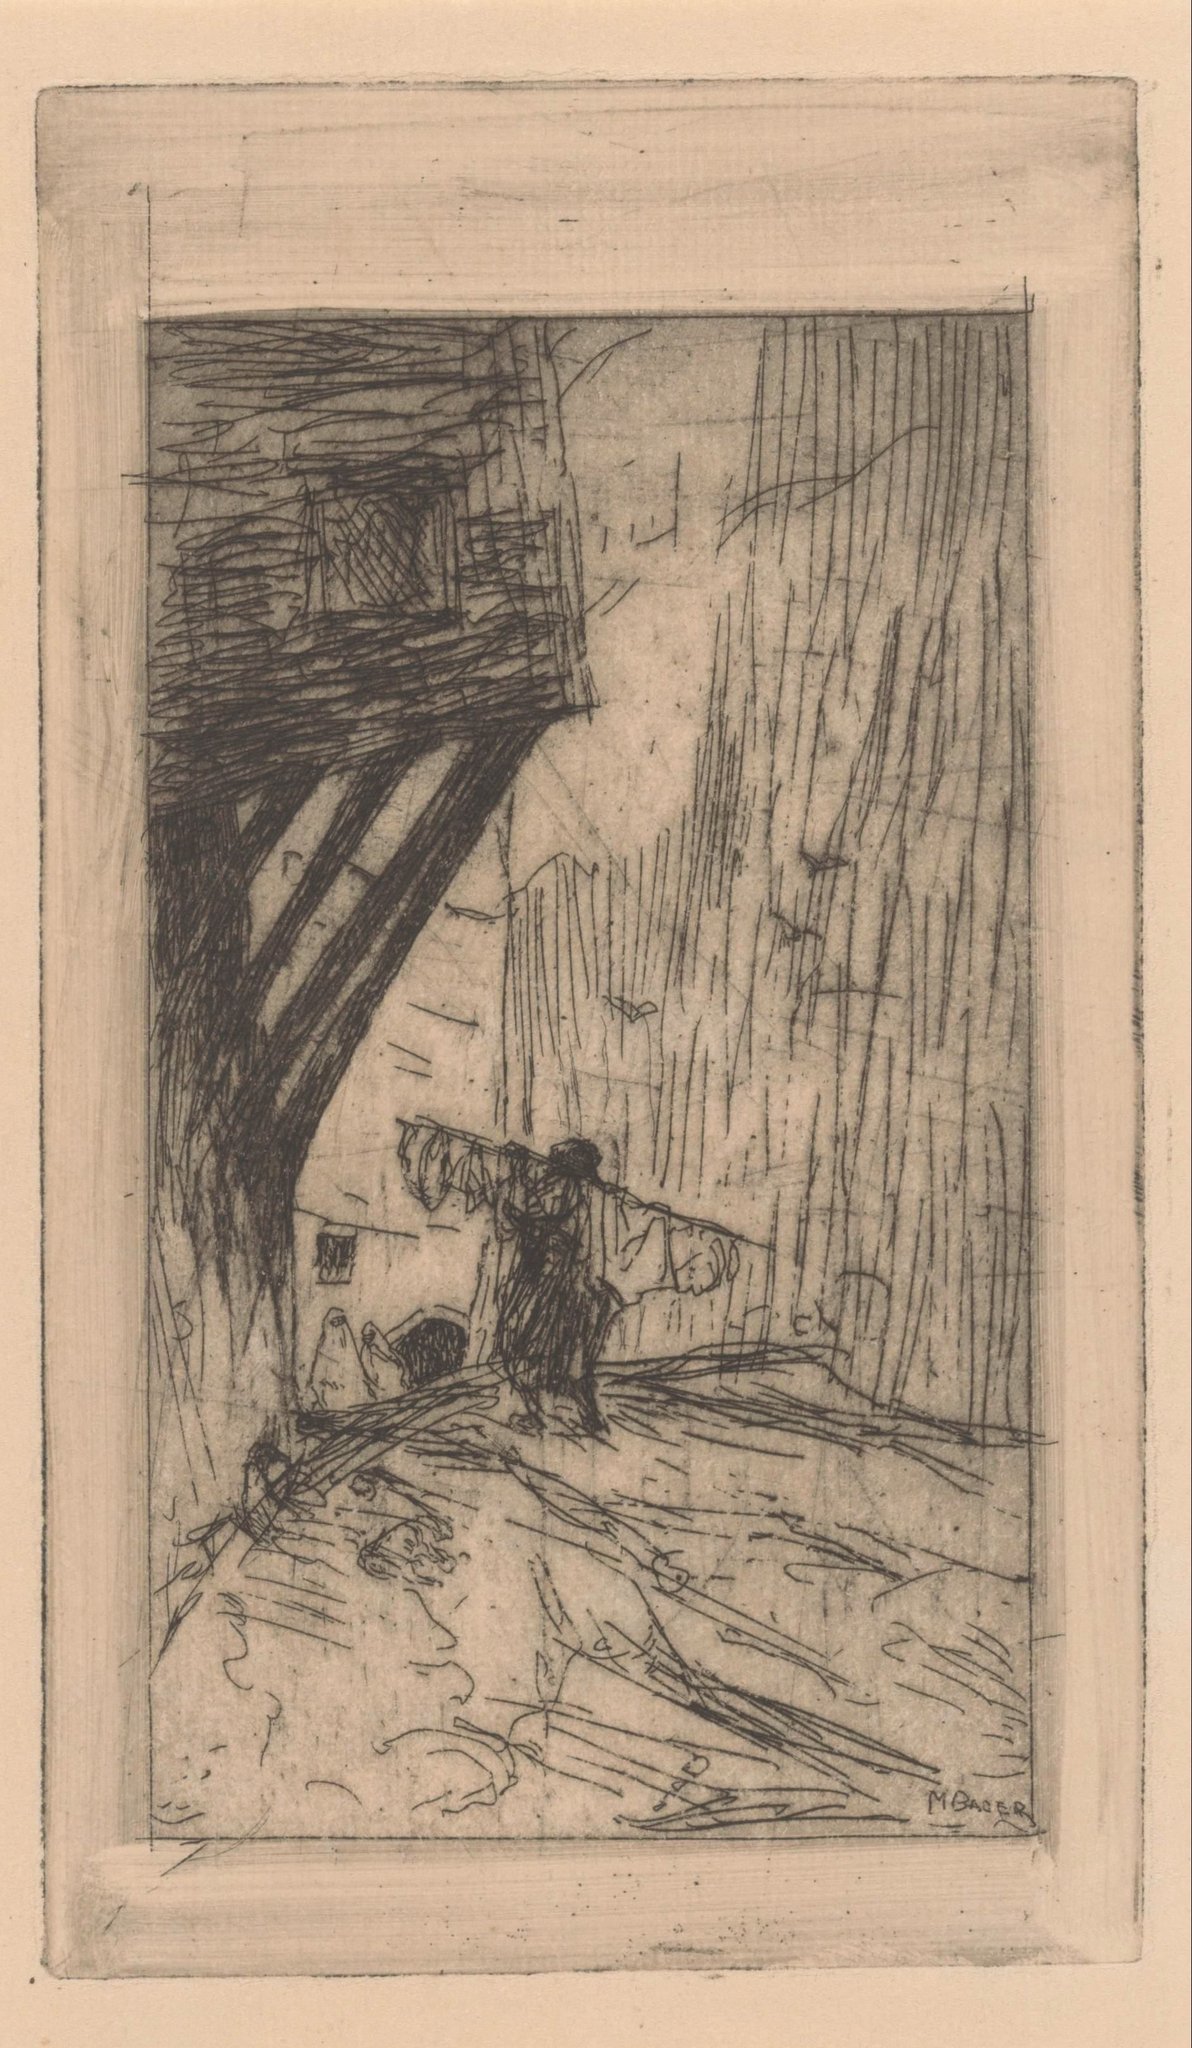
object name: print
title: Ottomaanse vleesverkoper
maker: marius bauer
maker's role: draughtsman, print maker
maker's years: 1867-1932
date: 1888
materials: paper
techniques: etching, intaglio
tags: butcher, slaughterman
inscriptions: collector's mark: Lugt 2228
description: Een straat met daarin een man die op zijn schouder een stok met lappen vlees draagt. Op de achtergrond twee gesluierde vrouwen.